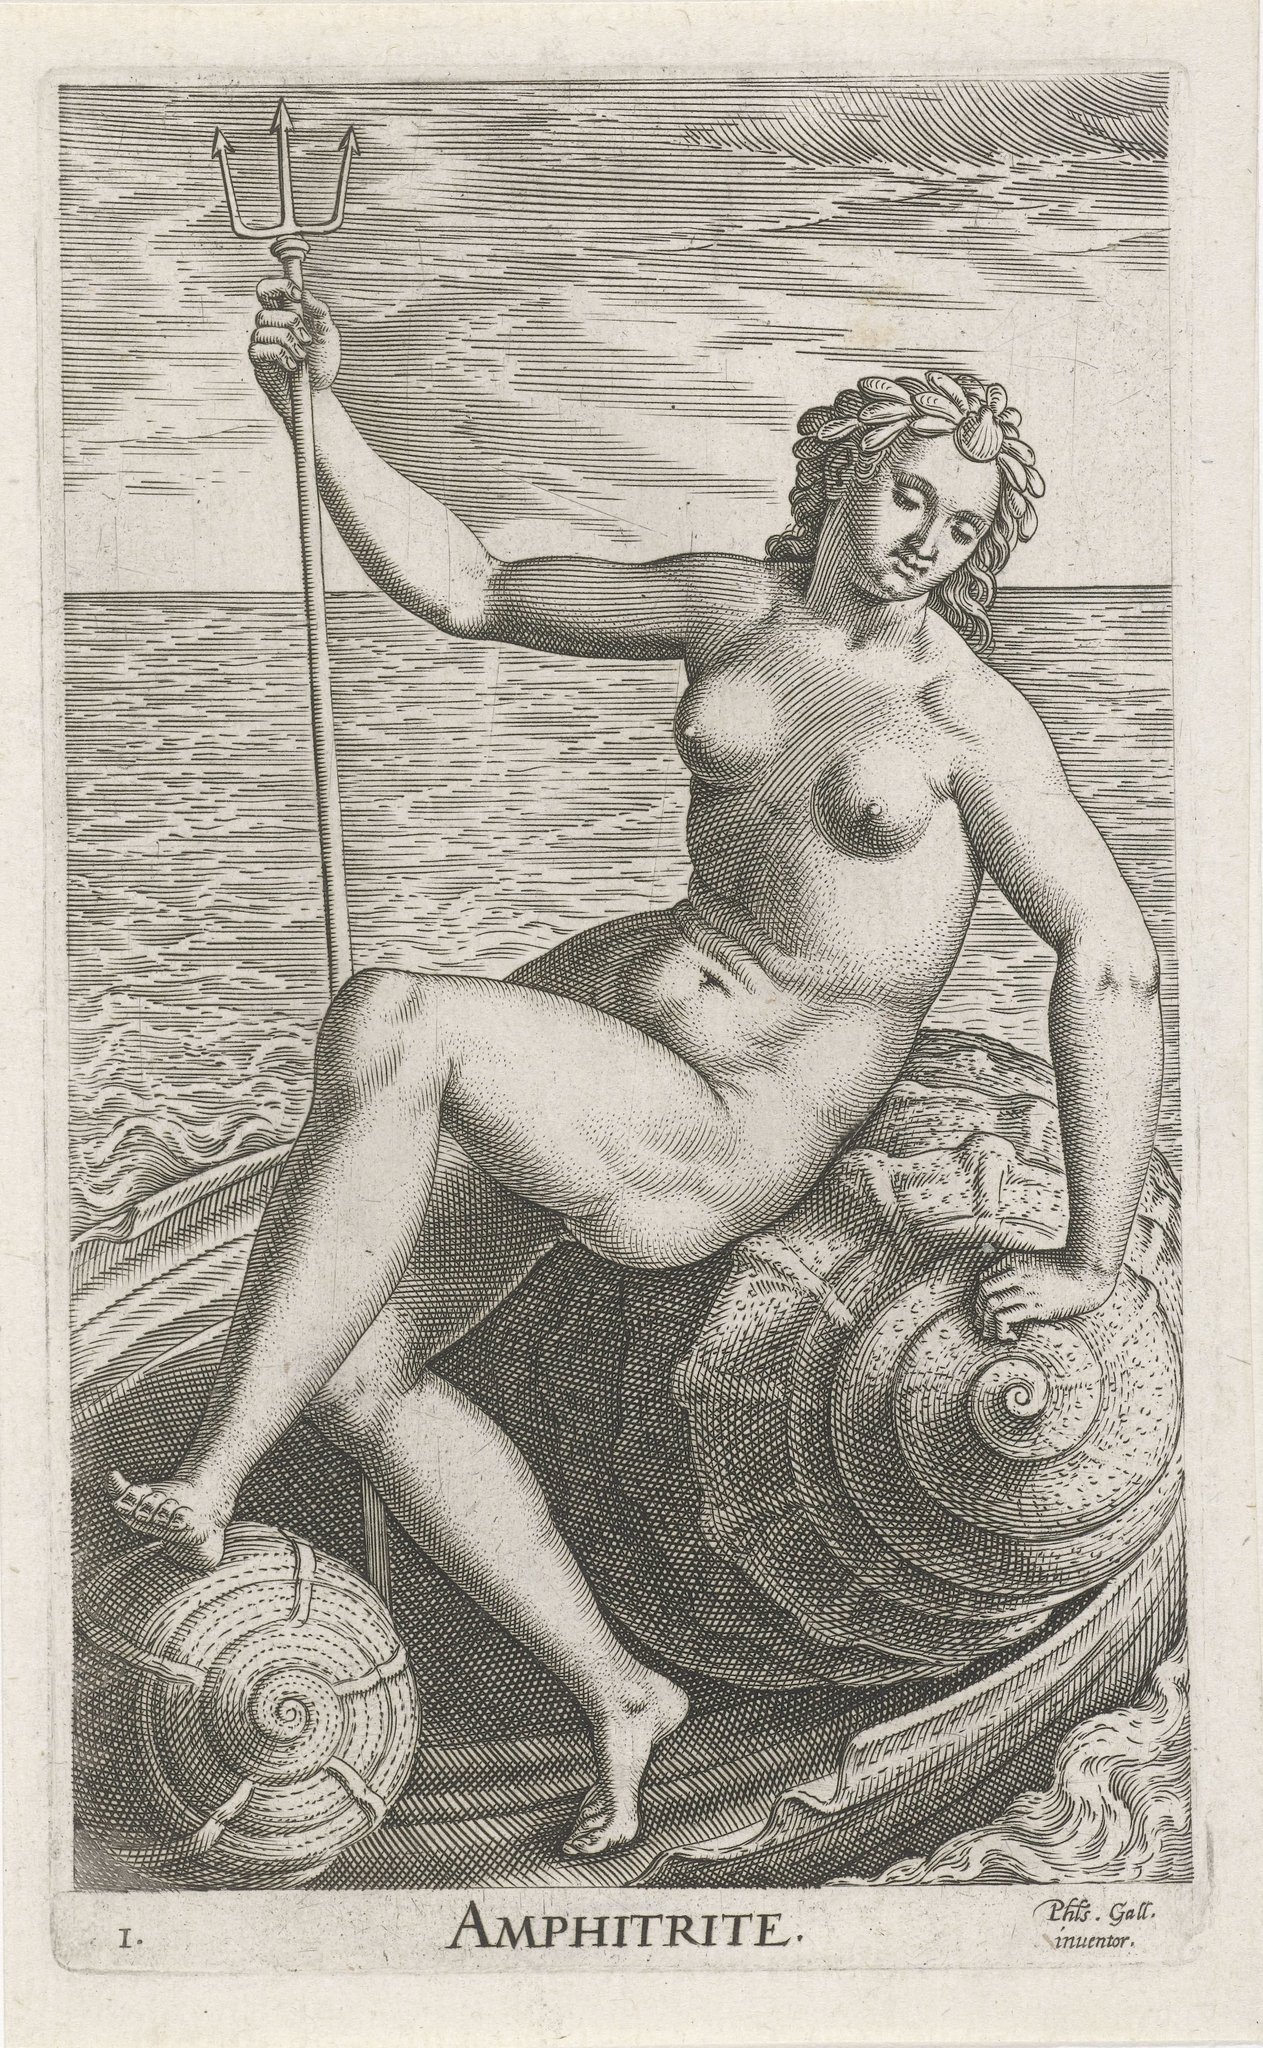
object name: print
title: Nimpharum oceanitidum, ephydridum potamidum naiadum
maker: philips galle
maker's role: print maker, publisher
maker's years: 1537-1612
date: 1587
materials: paper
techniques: engraving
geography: antwerp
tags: (story of) amphitrite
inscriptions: collector's mark: Lugt 2228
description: De zeegodin Amphitrite, gezeten op een schelp. De prent maakt deel uit van een zeventiendelige serie over stroom- en waternimfen